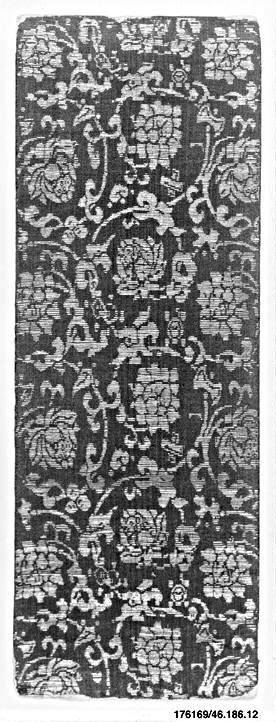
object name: sutra cover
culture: chinese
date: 1801-1900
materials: metal thread, silk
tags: flowers